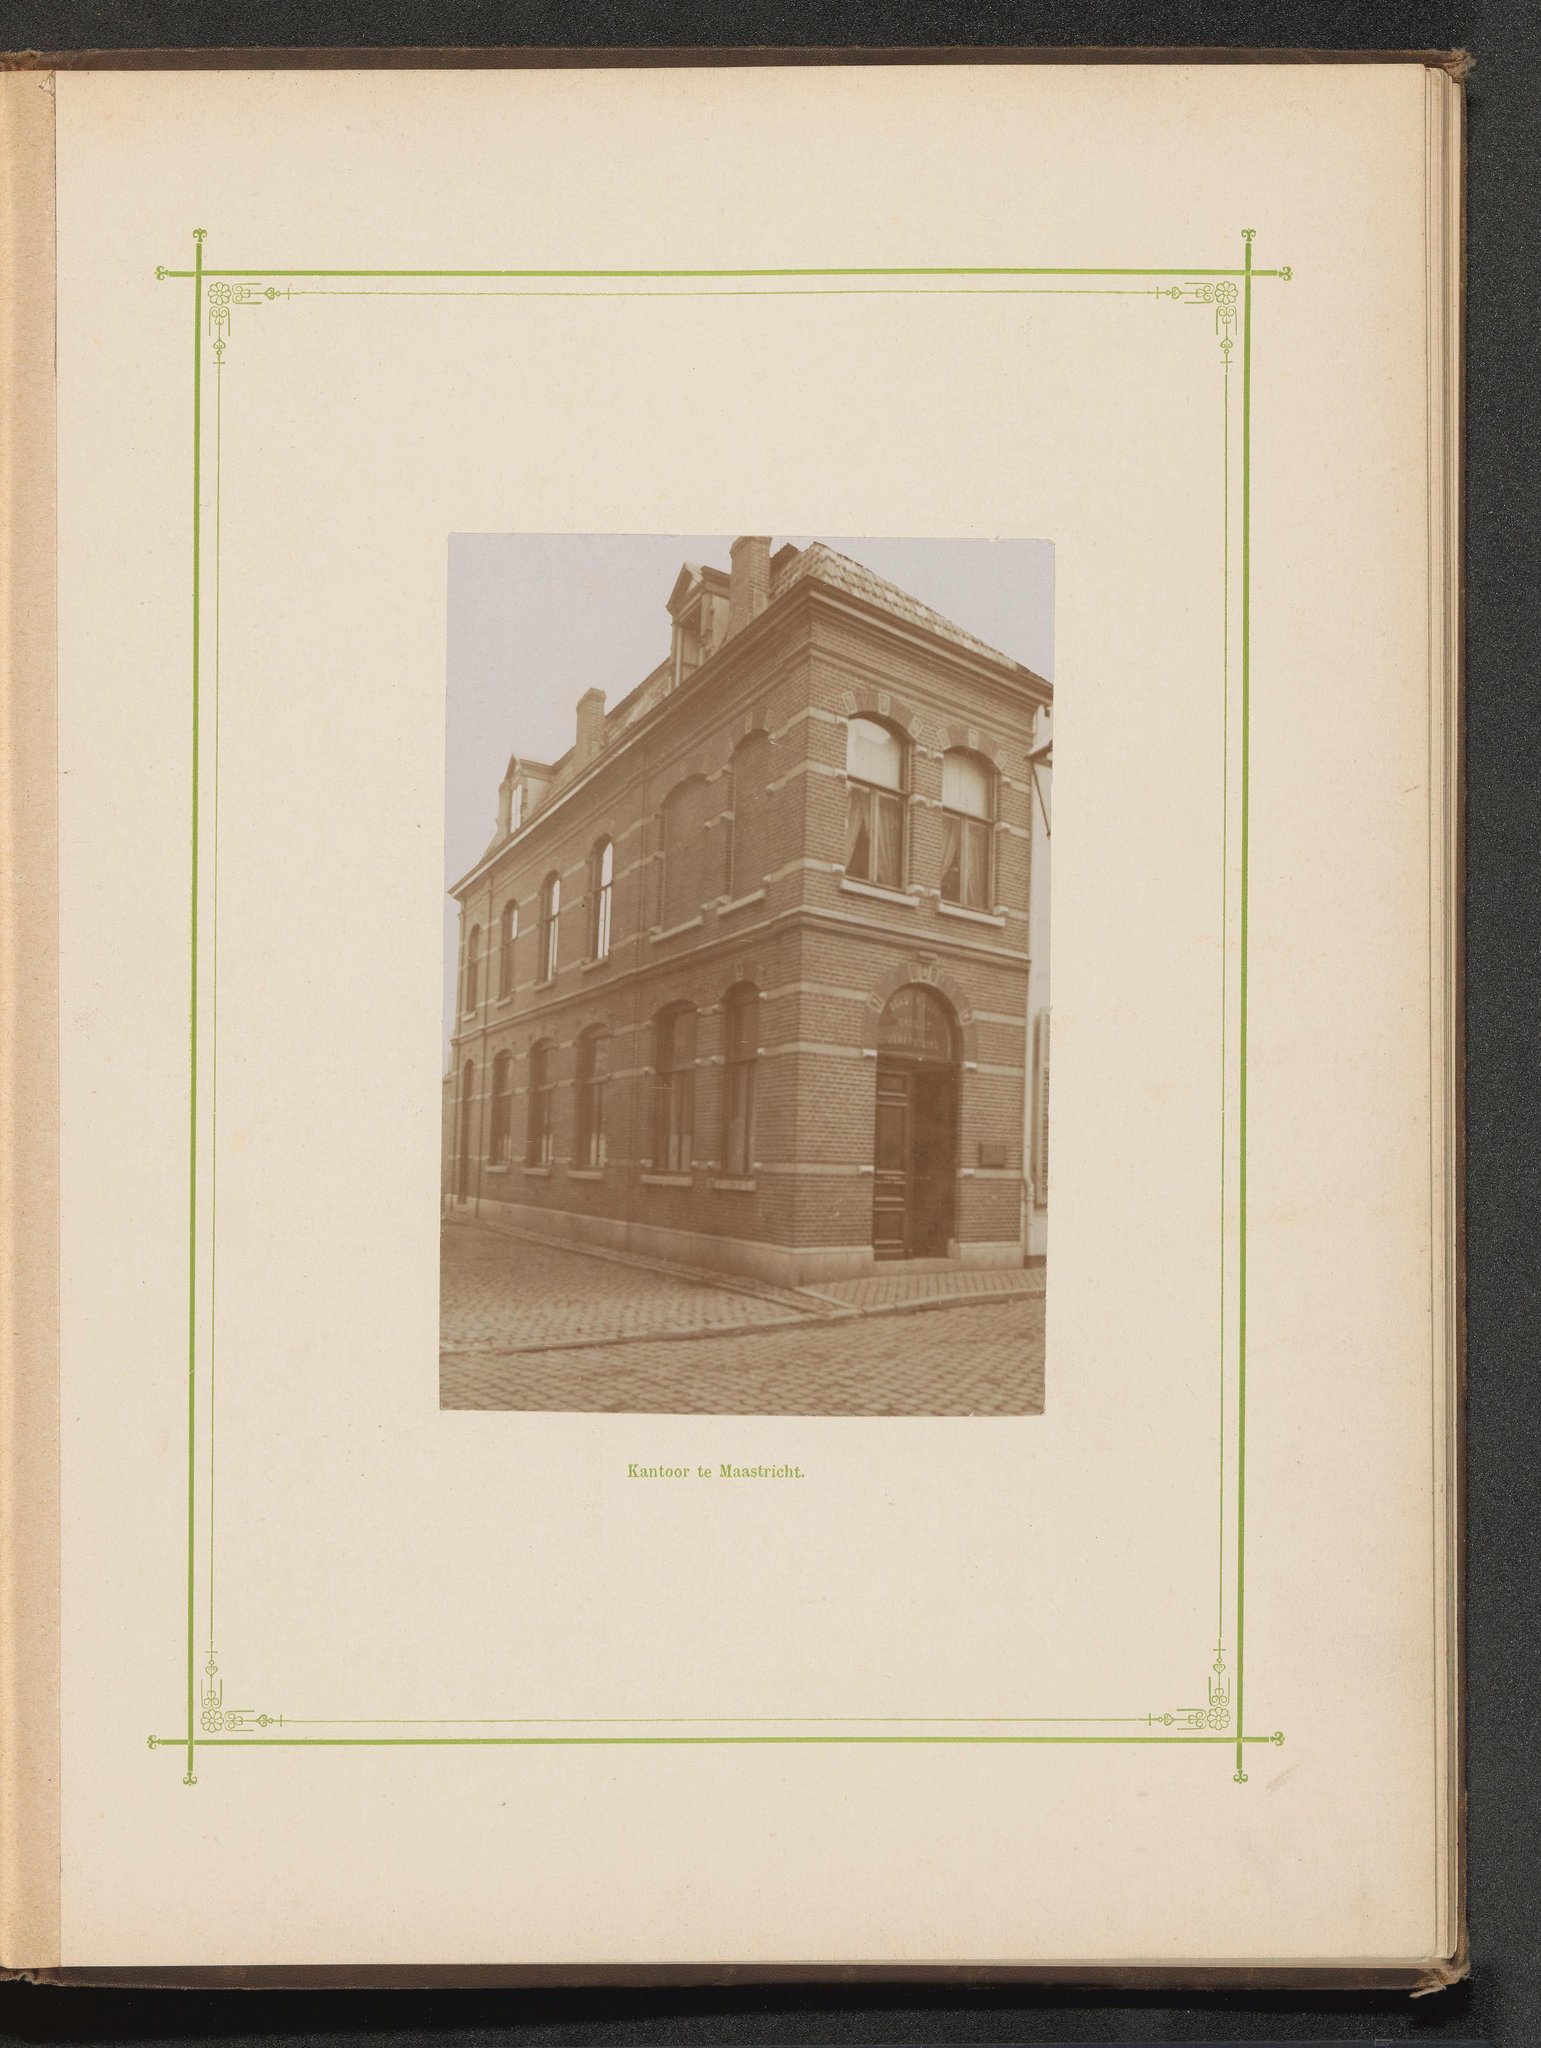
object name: page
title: Kantoor te Maastricht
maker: Anonymous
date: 1891-1892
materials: photographic support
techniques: collodion silver print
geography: maastricht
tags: façade (of house or building), maastricht